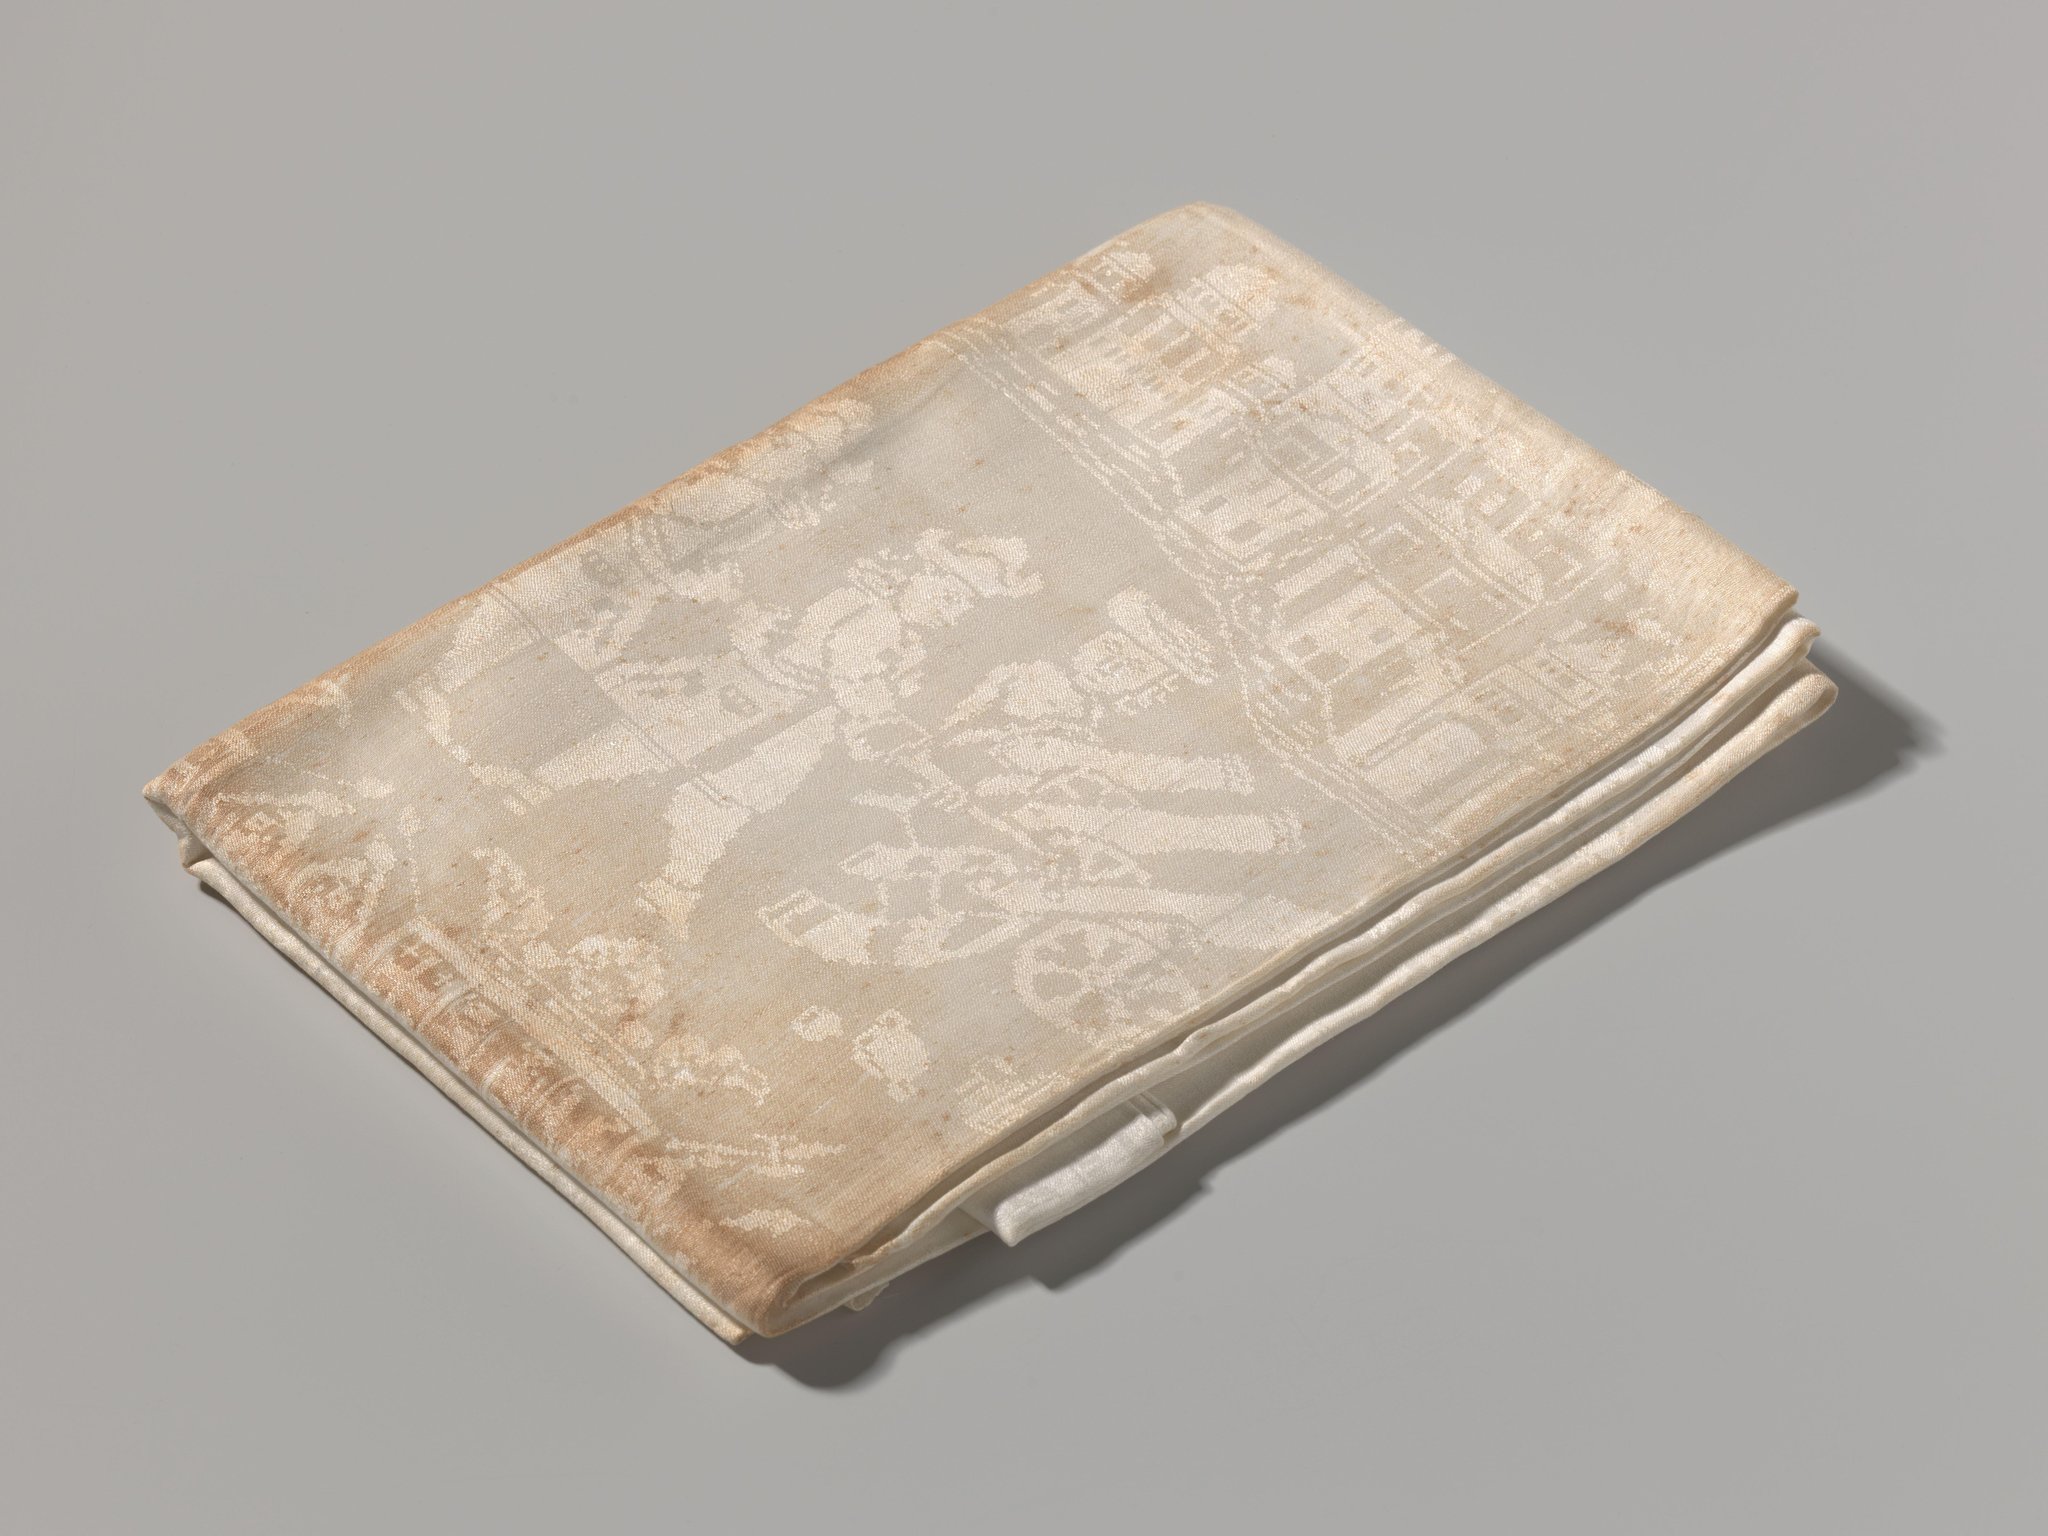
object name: tablecloth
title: Tafellaken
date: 1717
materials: linen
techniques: damask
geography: southern netherlands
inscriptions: mark: ‘DA’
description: Wit linnen damasten tafellaken met de verovering van Belgrado en met de inweving "BELGRADE" en "TEMESWAR", gemerkt DA.